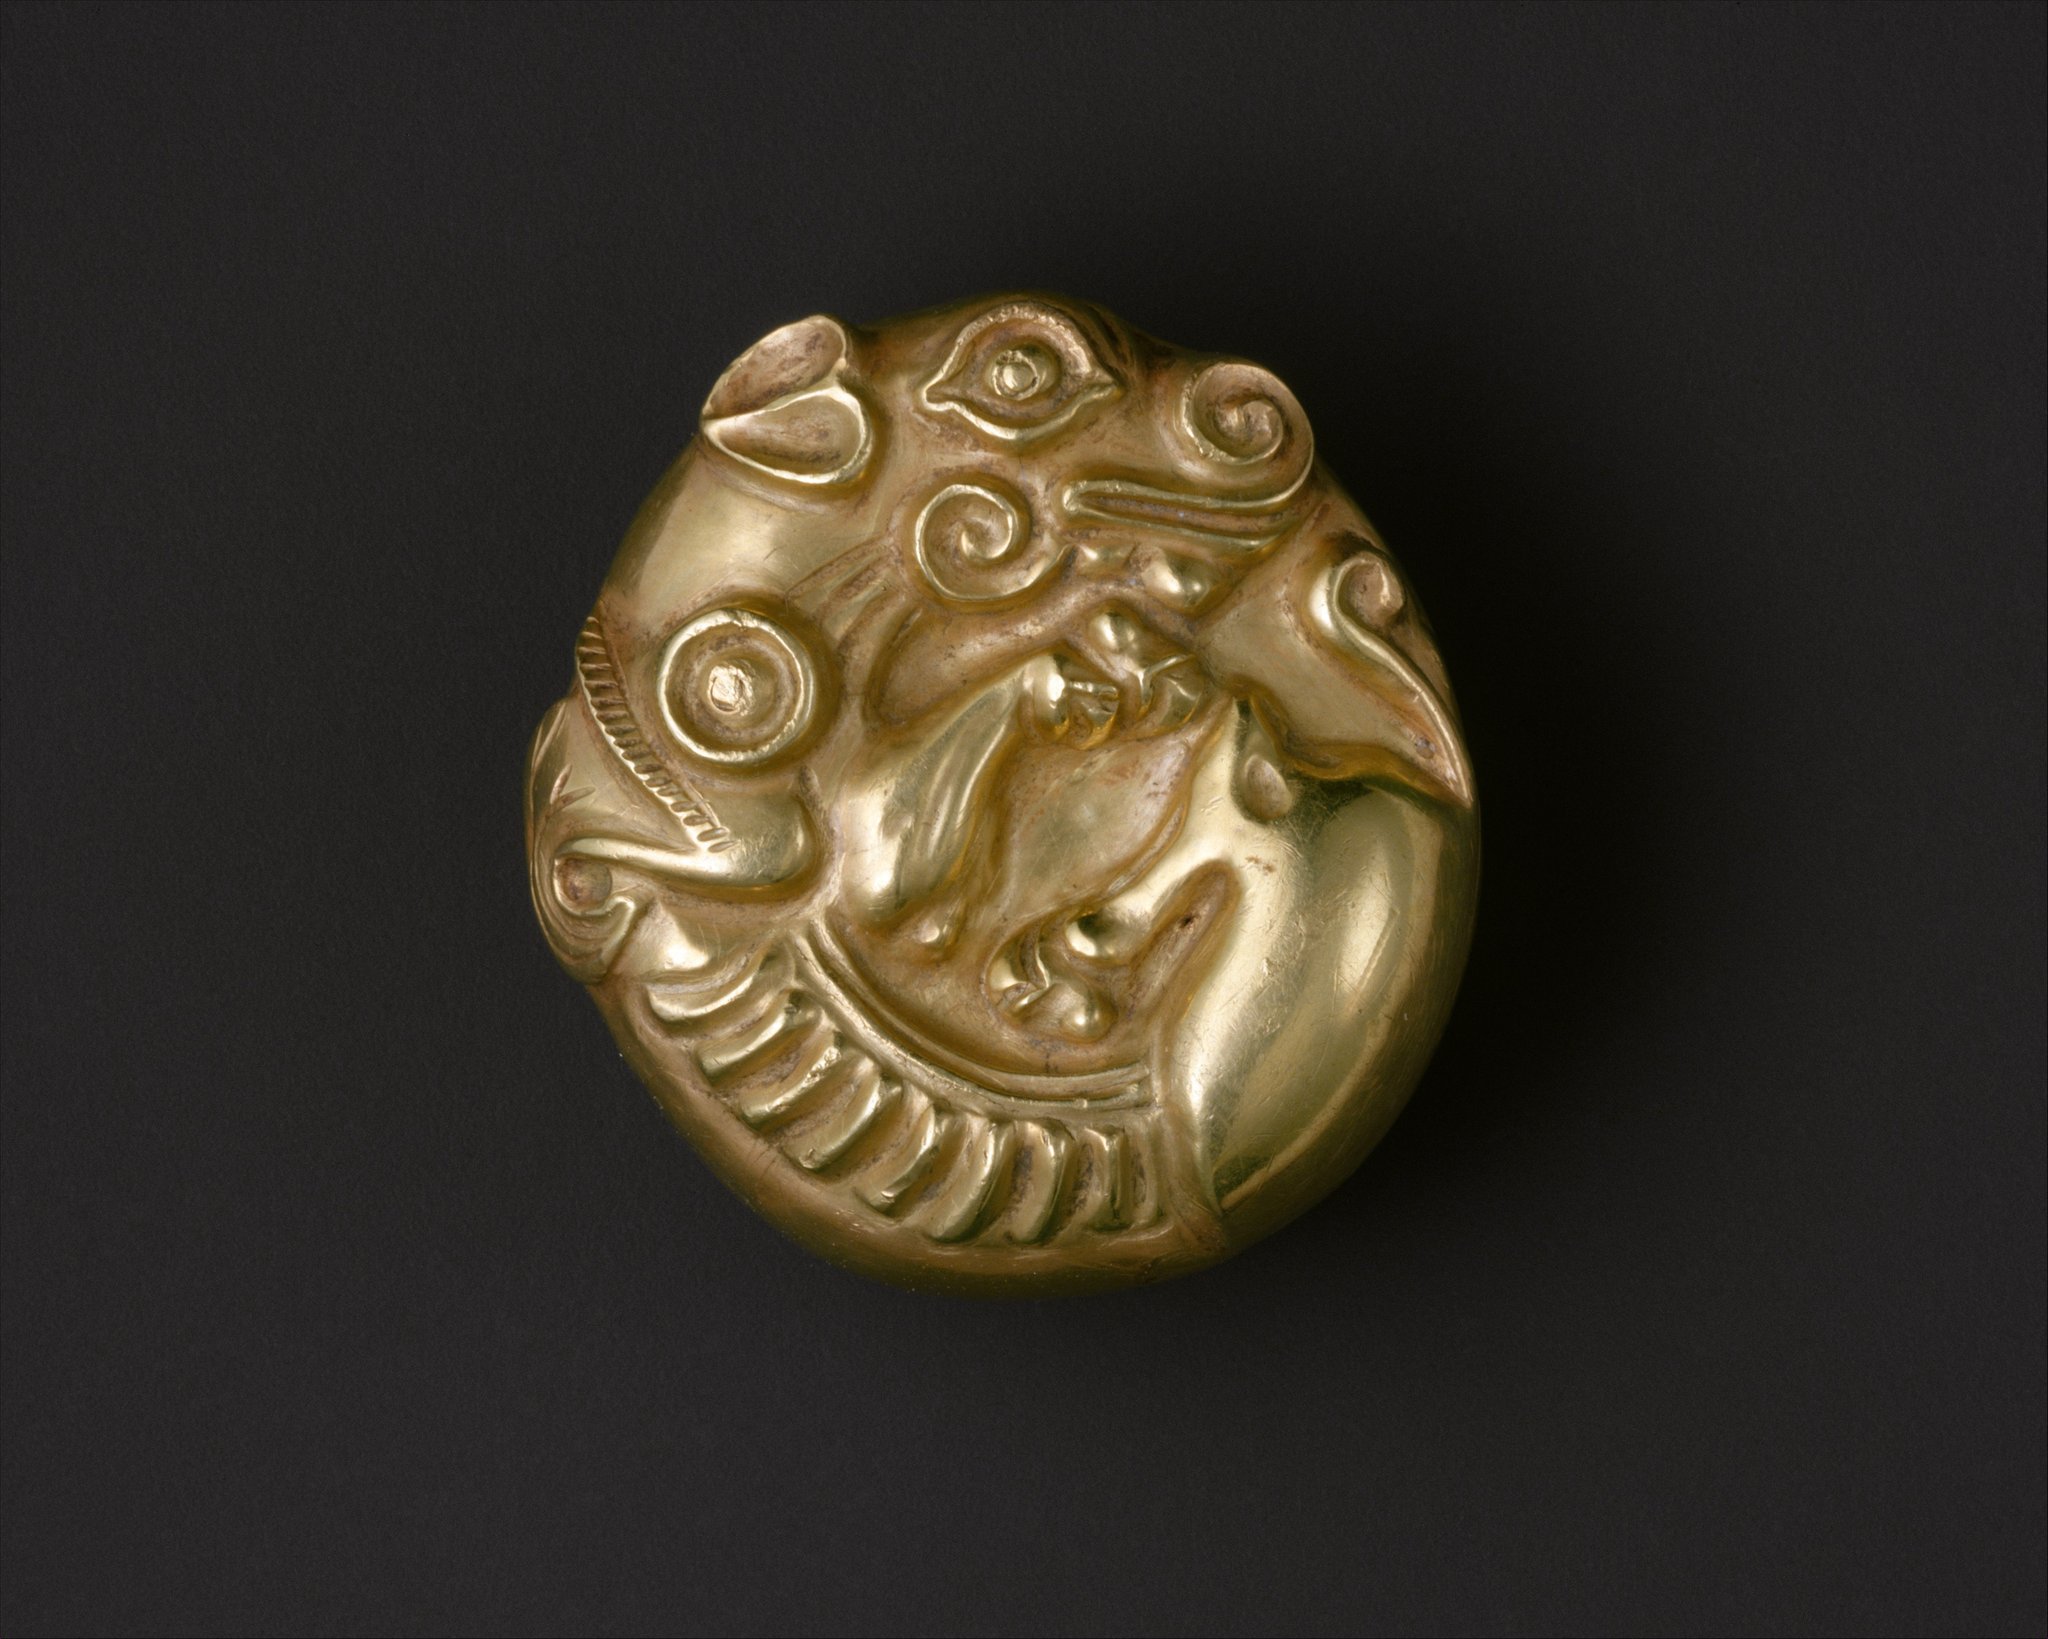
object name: pommel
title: Pommel in the shape of coiled animals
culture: scythian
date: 600-501 BCE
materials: gold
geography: iran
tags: animals